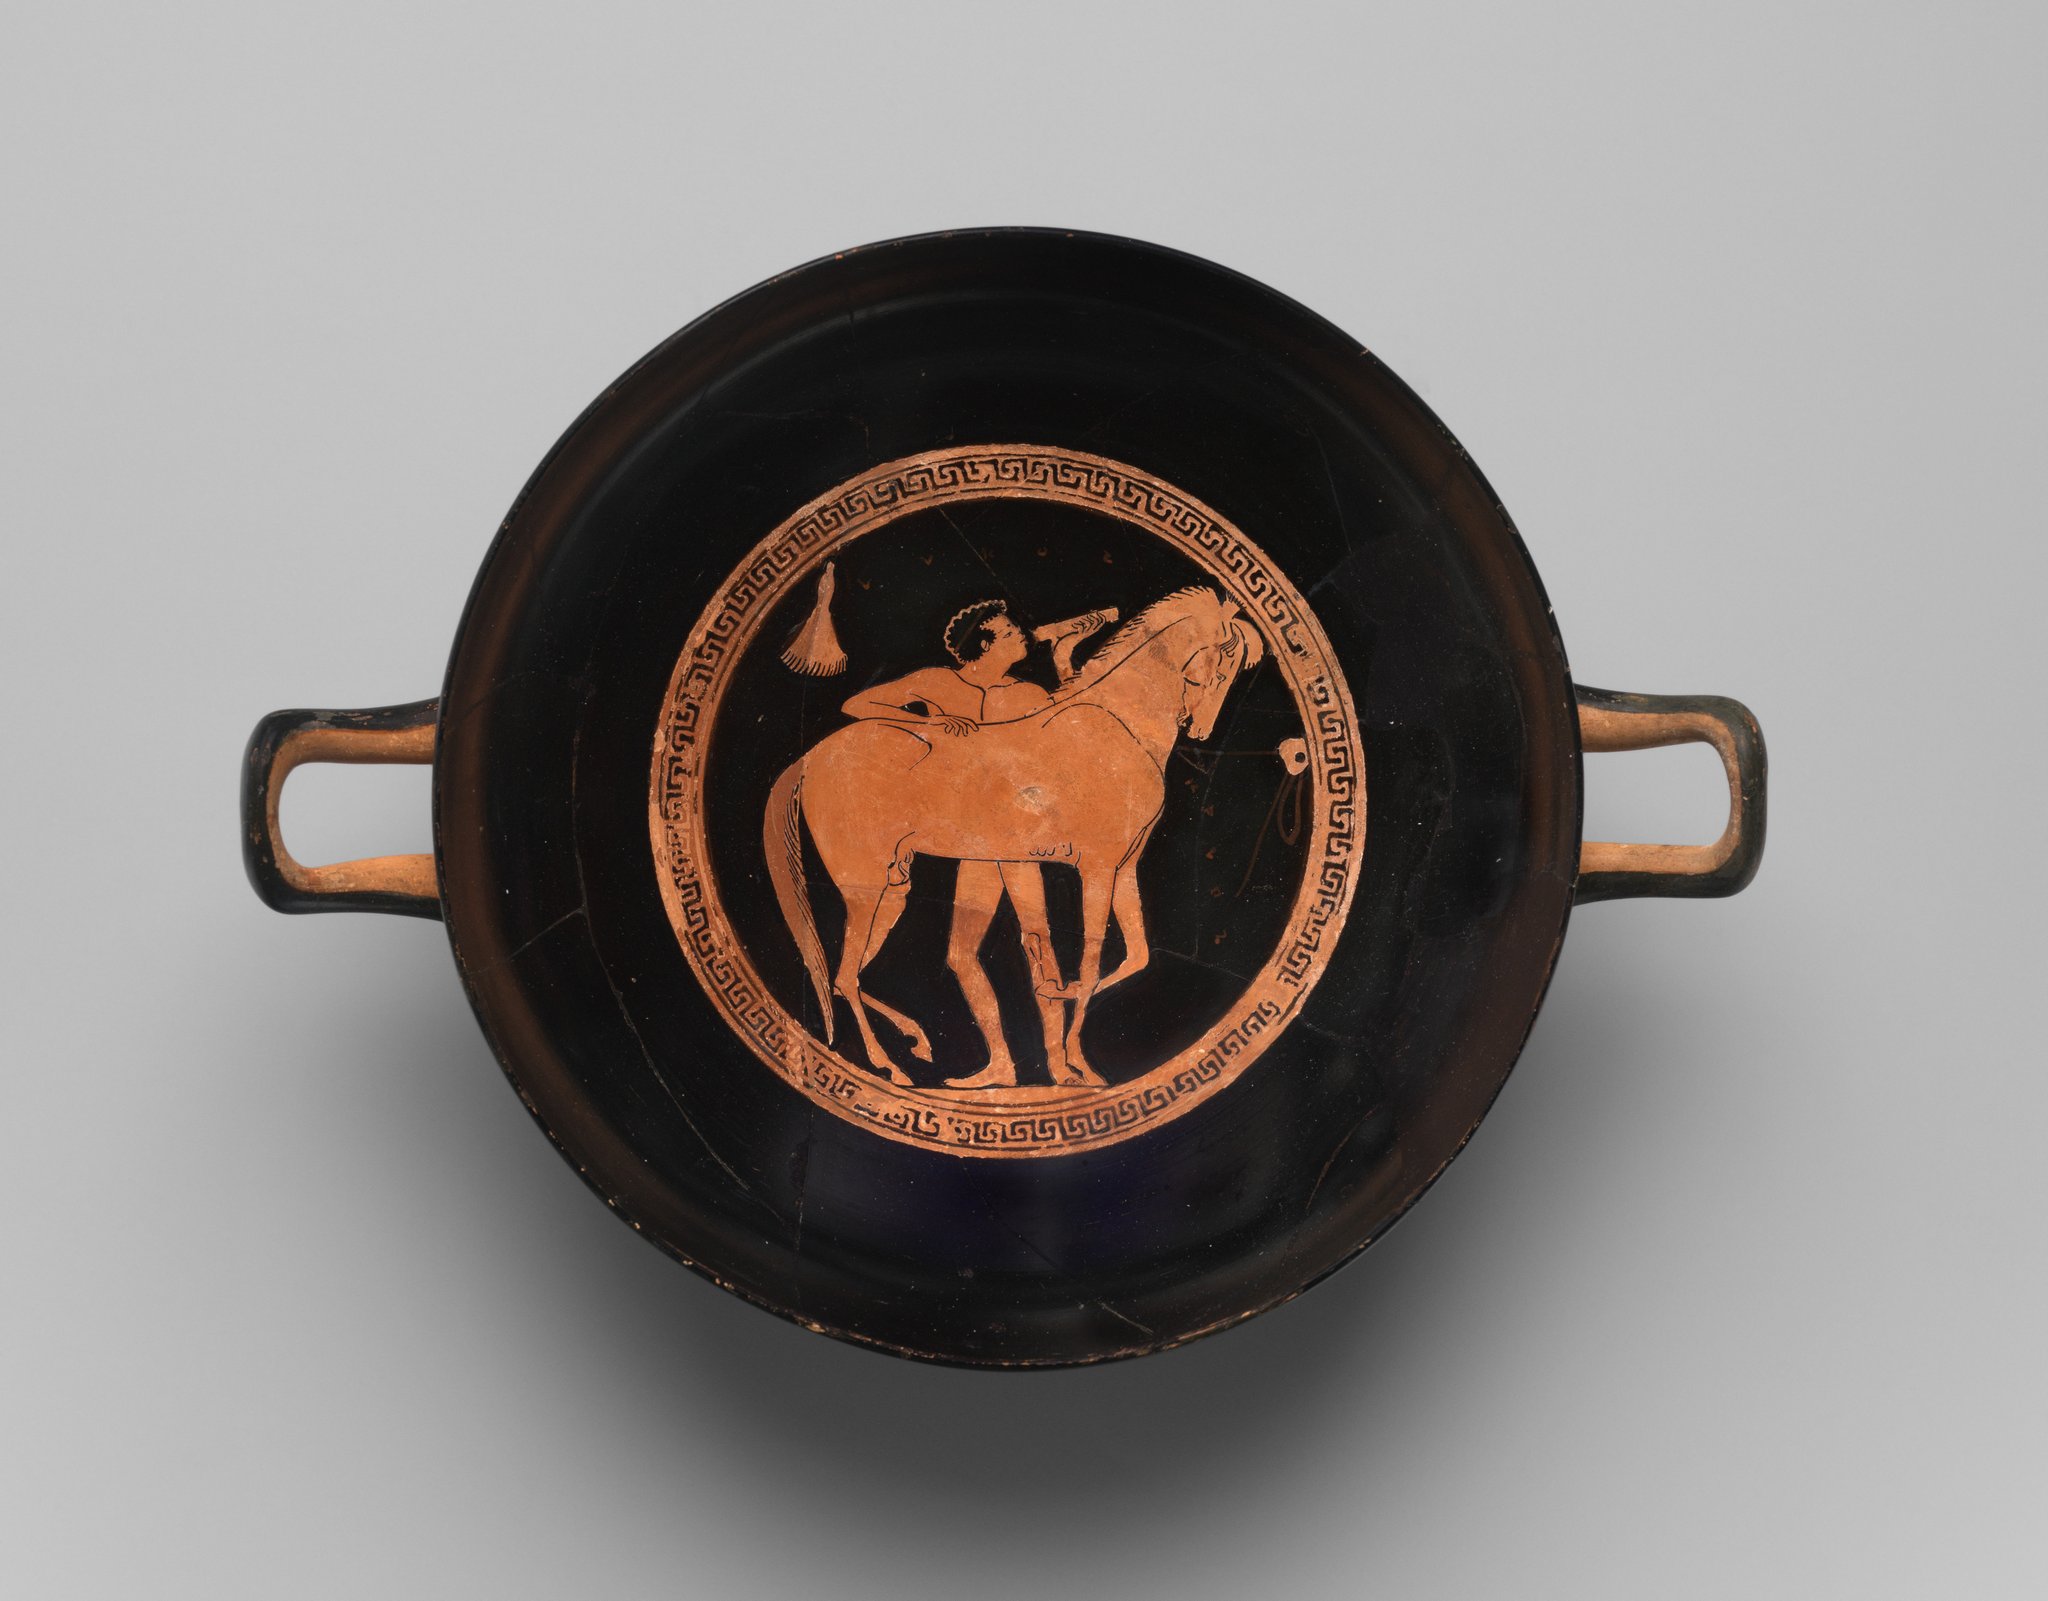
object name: kylix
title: Terracotta kylix (drinking cup)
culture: greek, attic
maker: onesimos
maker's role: artist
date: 490 BCE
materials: terracotta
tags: men,horses